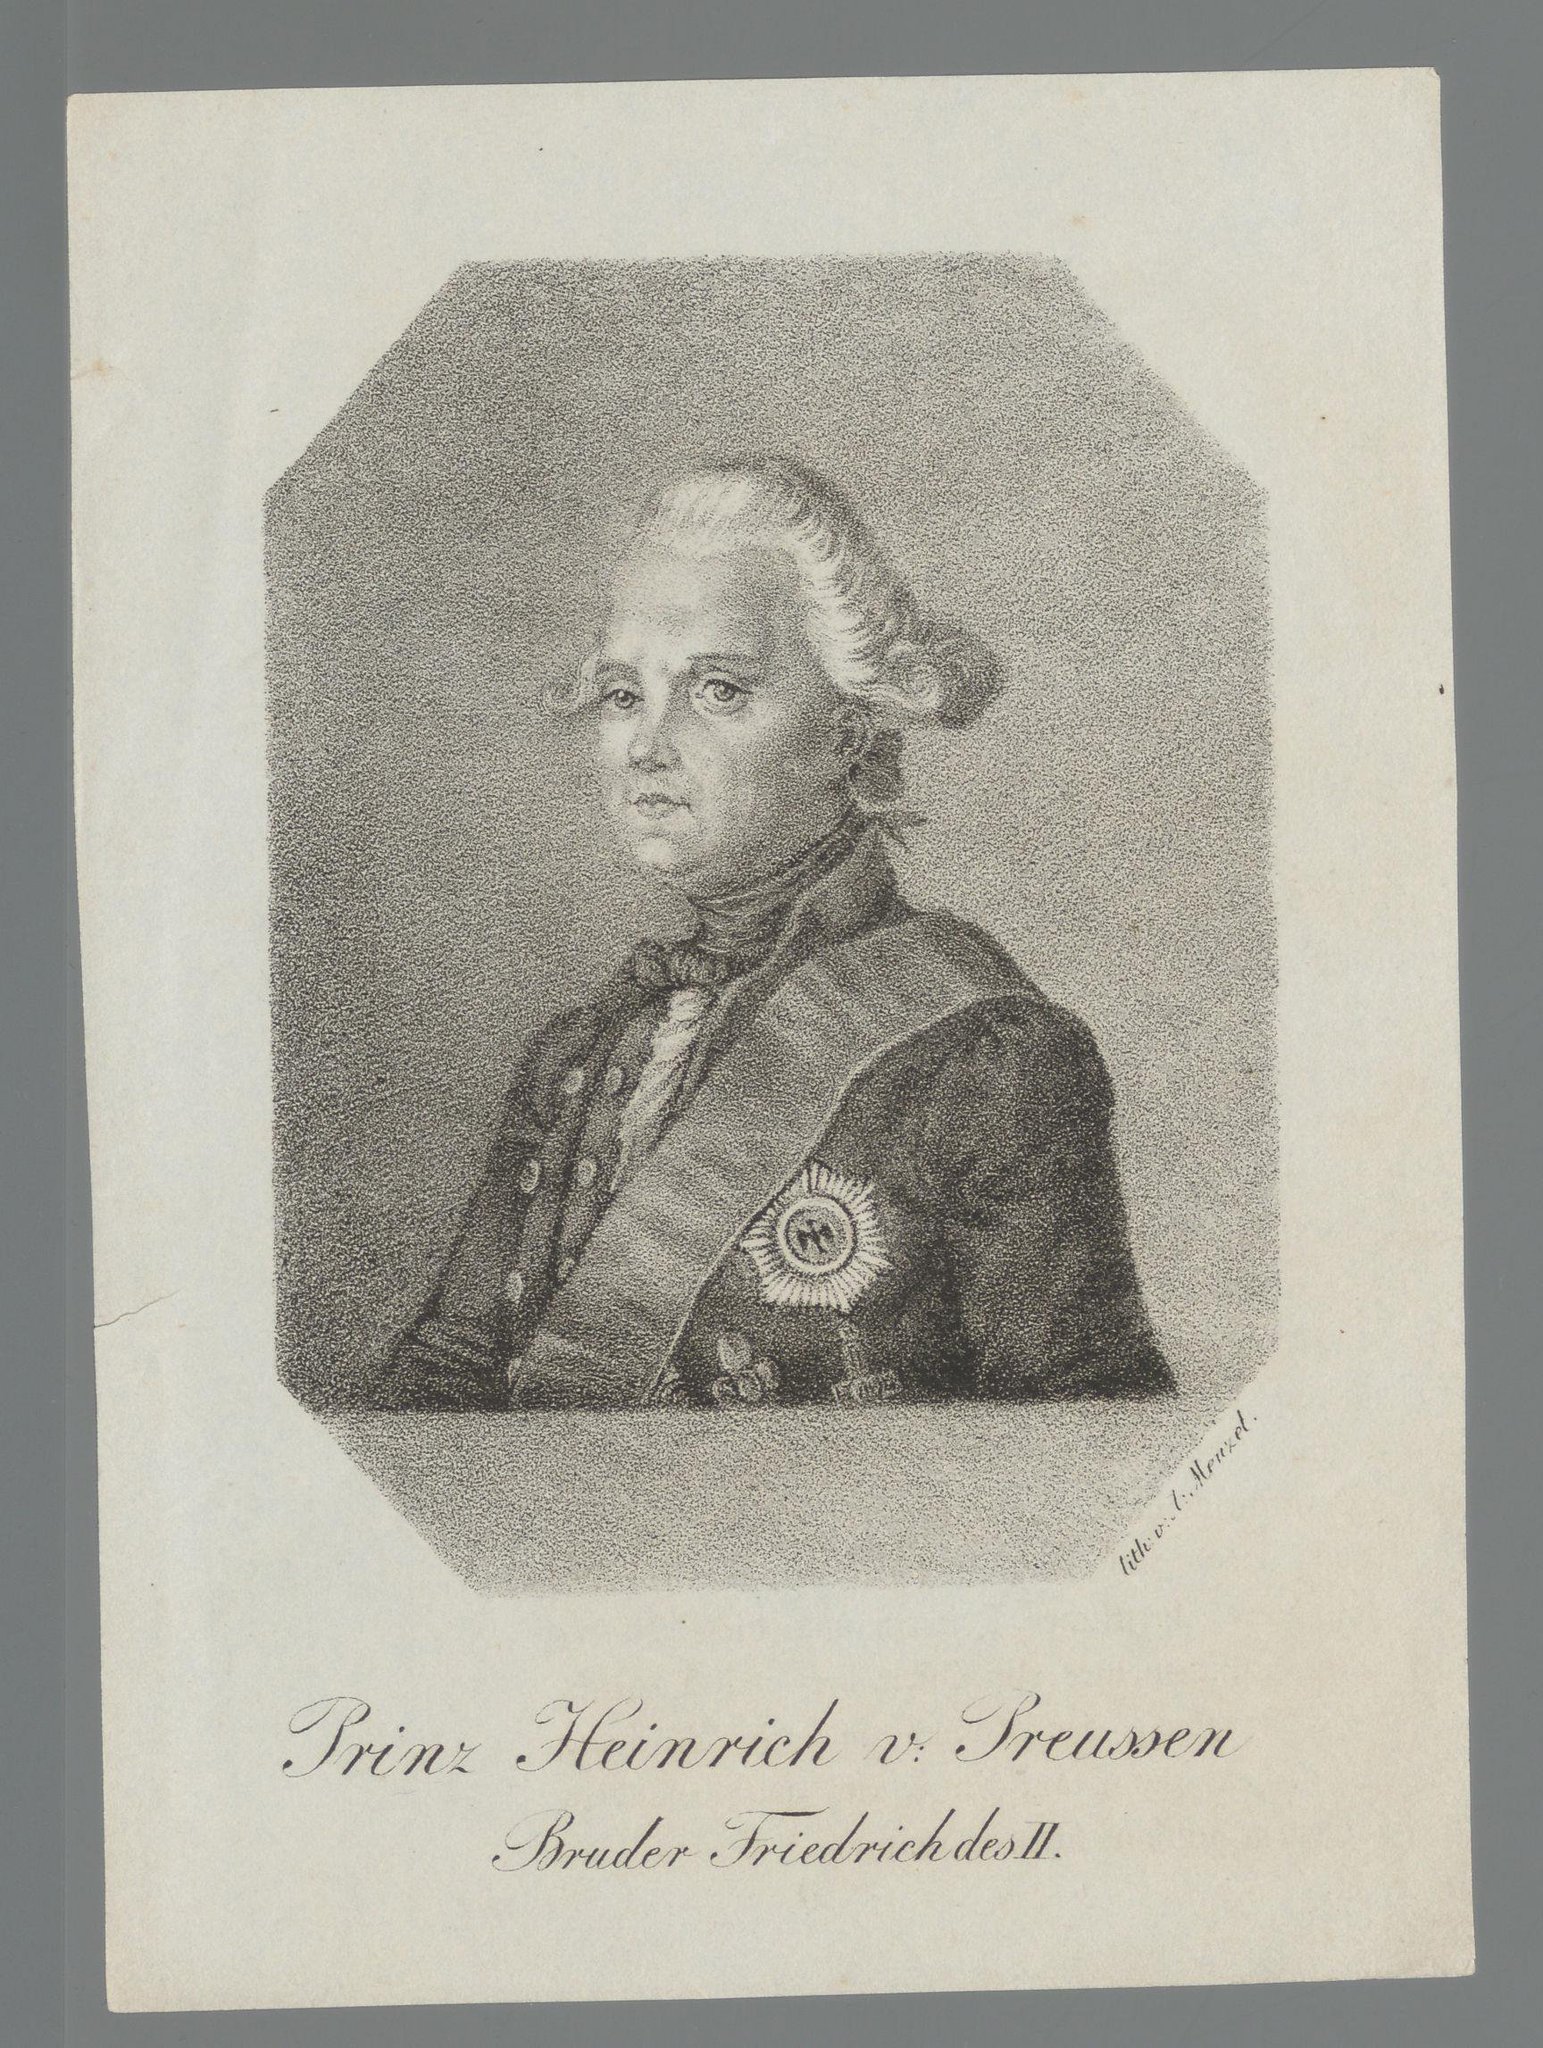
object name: print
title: Portret van Friedrich Heinrich Ludwig van Pruisen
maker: adolph menzel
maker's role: draughtsman, painter, print maker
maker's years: 1815-1905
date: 1825-1905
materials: paper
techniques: lithograph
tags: berlin, friedrich heinrich ludwig van pruisen, prince, historical persons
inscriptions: collector's mark: Lugt 2228